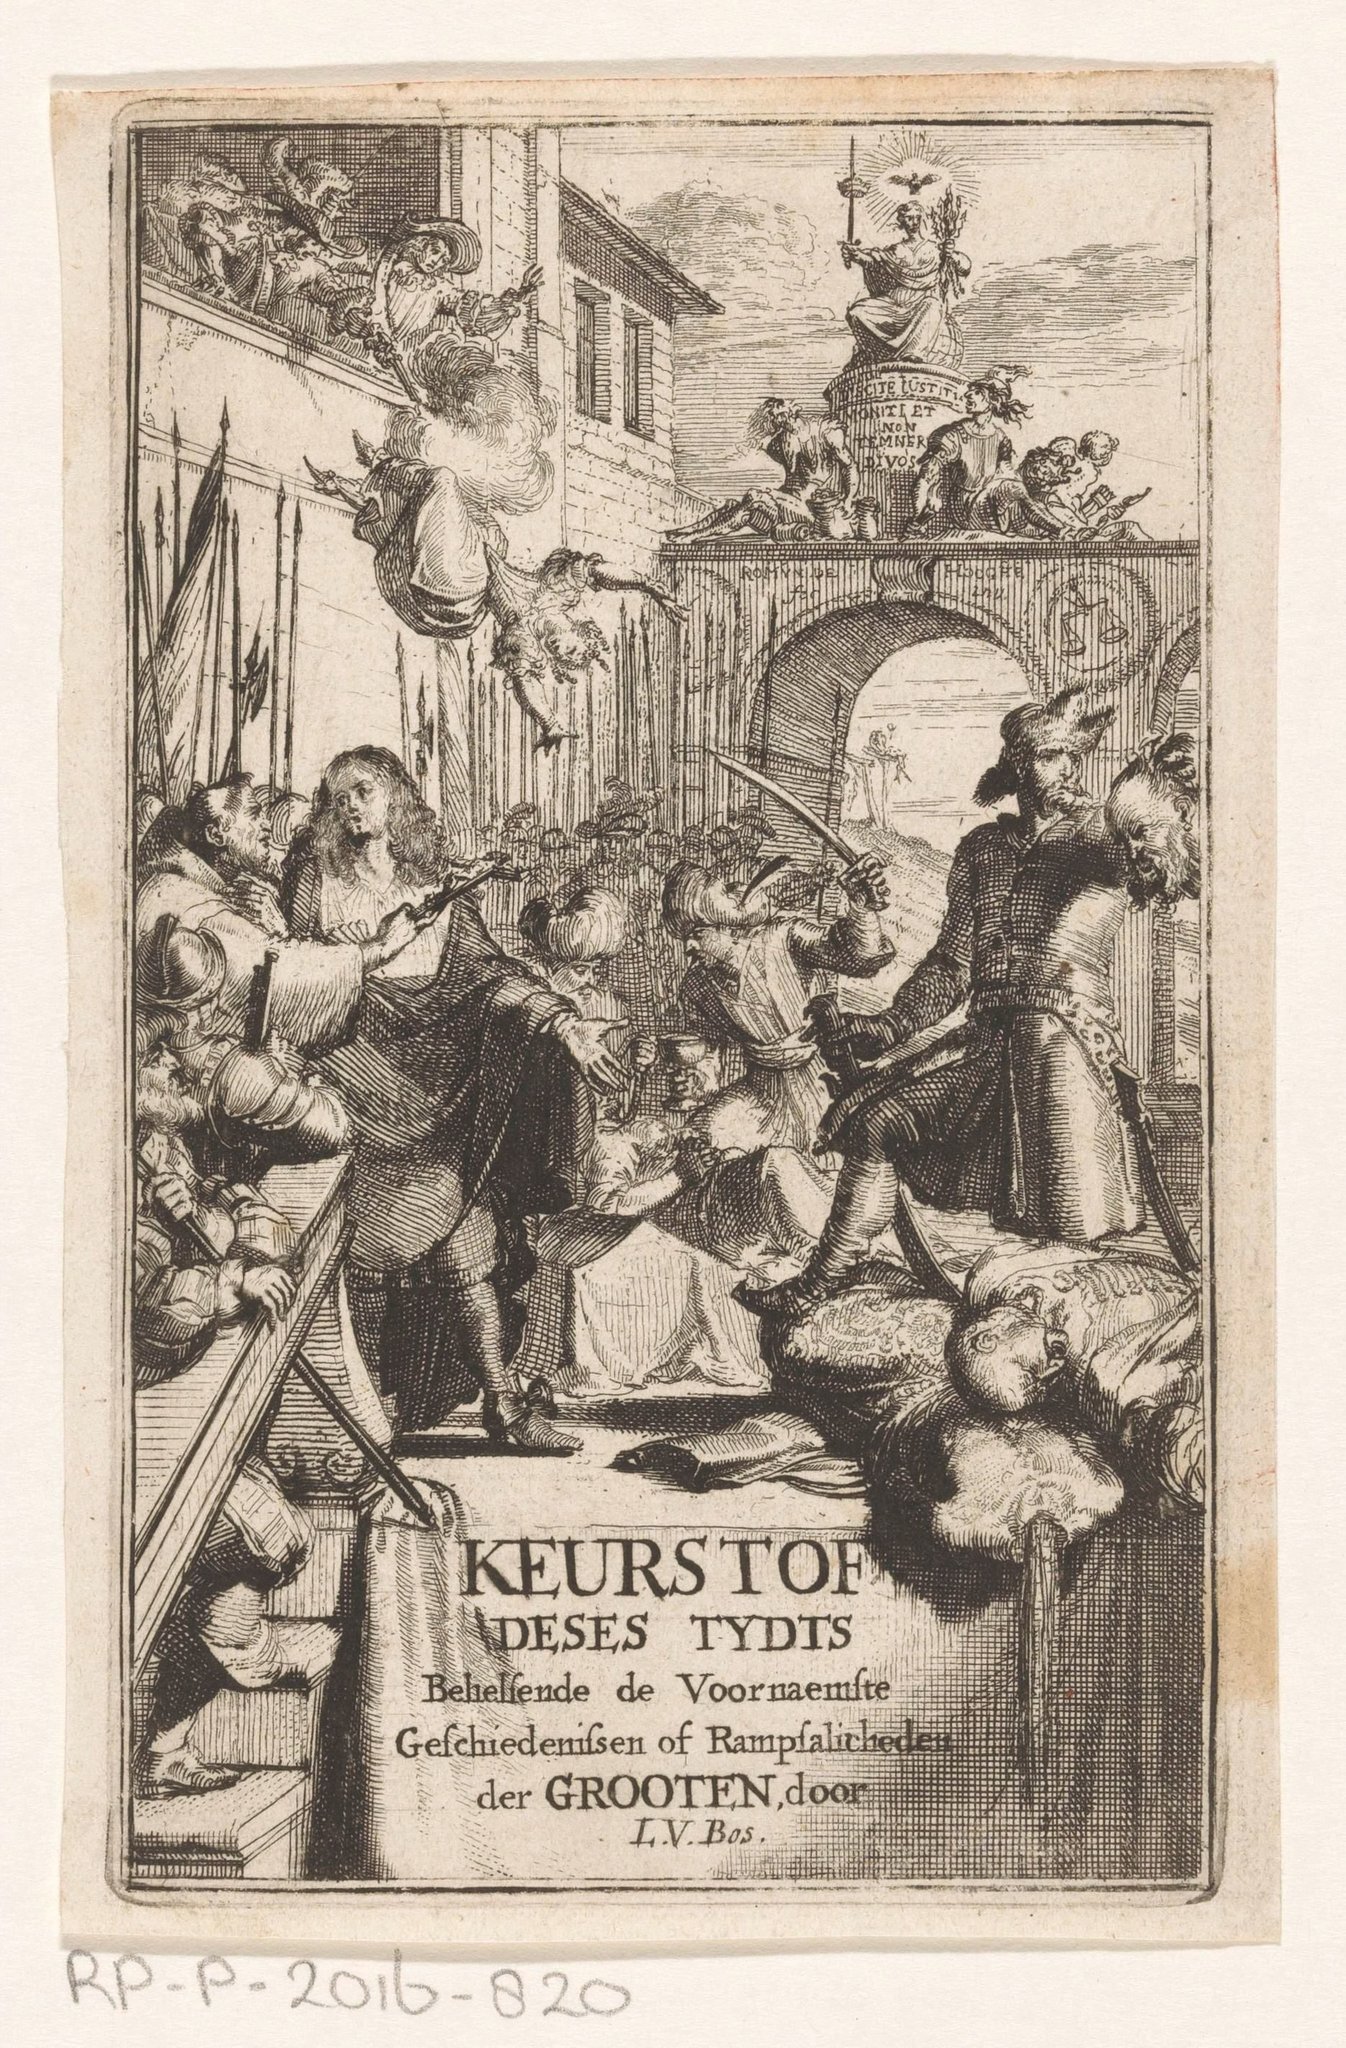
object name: print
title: Titelpagina voor: Lambert van den Bos, Keurstof deses tydts Behelsende de Voornaemste Geschiedenissen of Rampsalicheden der Grooten, 1672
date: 1672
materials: paper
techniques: etching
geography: dordrecht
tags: death penalty, execution, justitia (justice) as roman personification, violent death, being killed; being mishandled and maltreated; seeking death, violent death by beheading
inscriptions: collector's mark: Lugt 2228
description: Een jongeman wijst een monnik met kruis op executies op het schavot naast hen. Een man staat op twee lichamen en houdt een afgehakt hoofd omhoog. Daarachter twee mannen met tulband, één van hen houdt zijn zwaard in de lucht. Links wordt vanaf een balkon een vrouw naar beneden gegooid en op haar geschoten. In de achtergrond op een boog zit Vrouw Justitia op een troon omgeven door een oude vrouw en jonge soldaat.